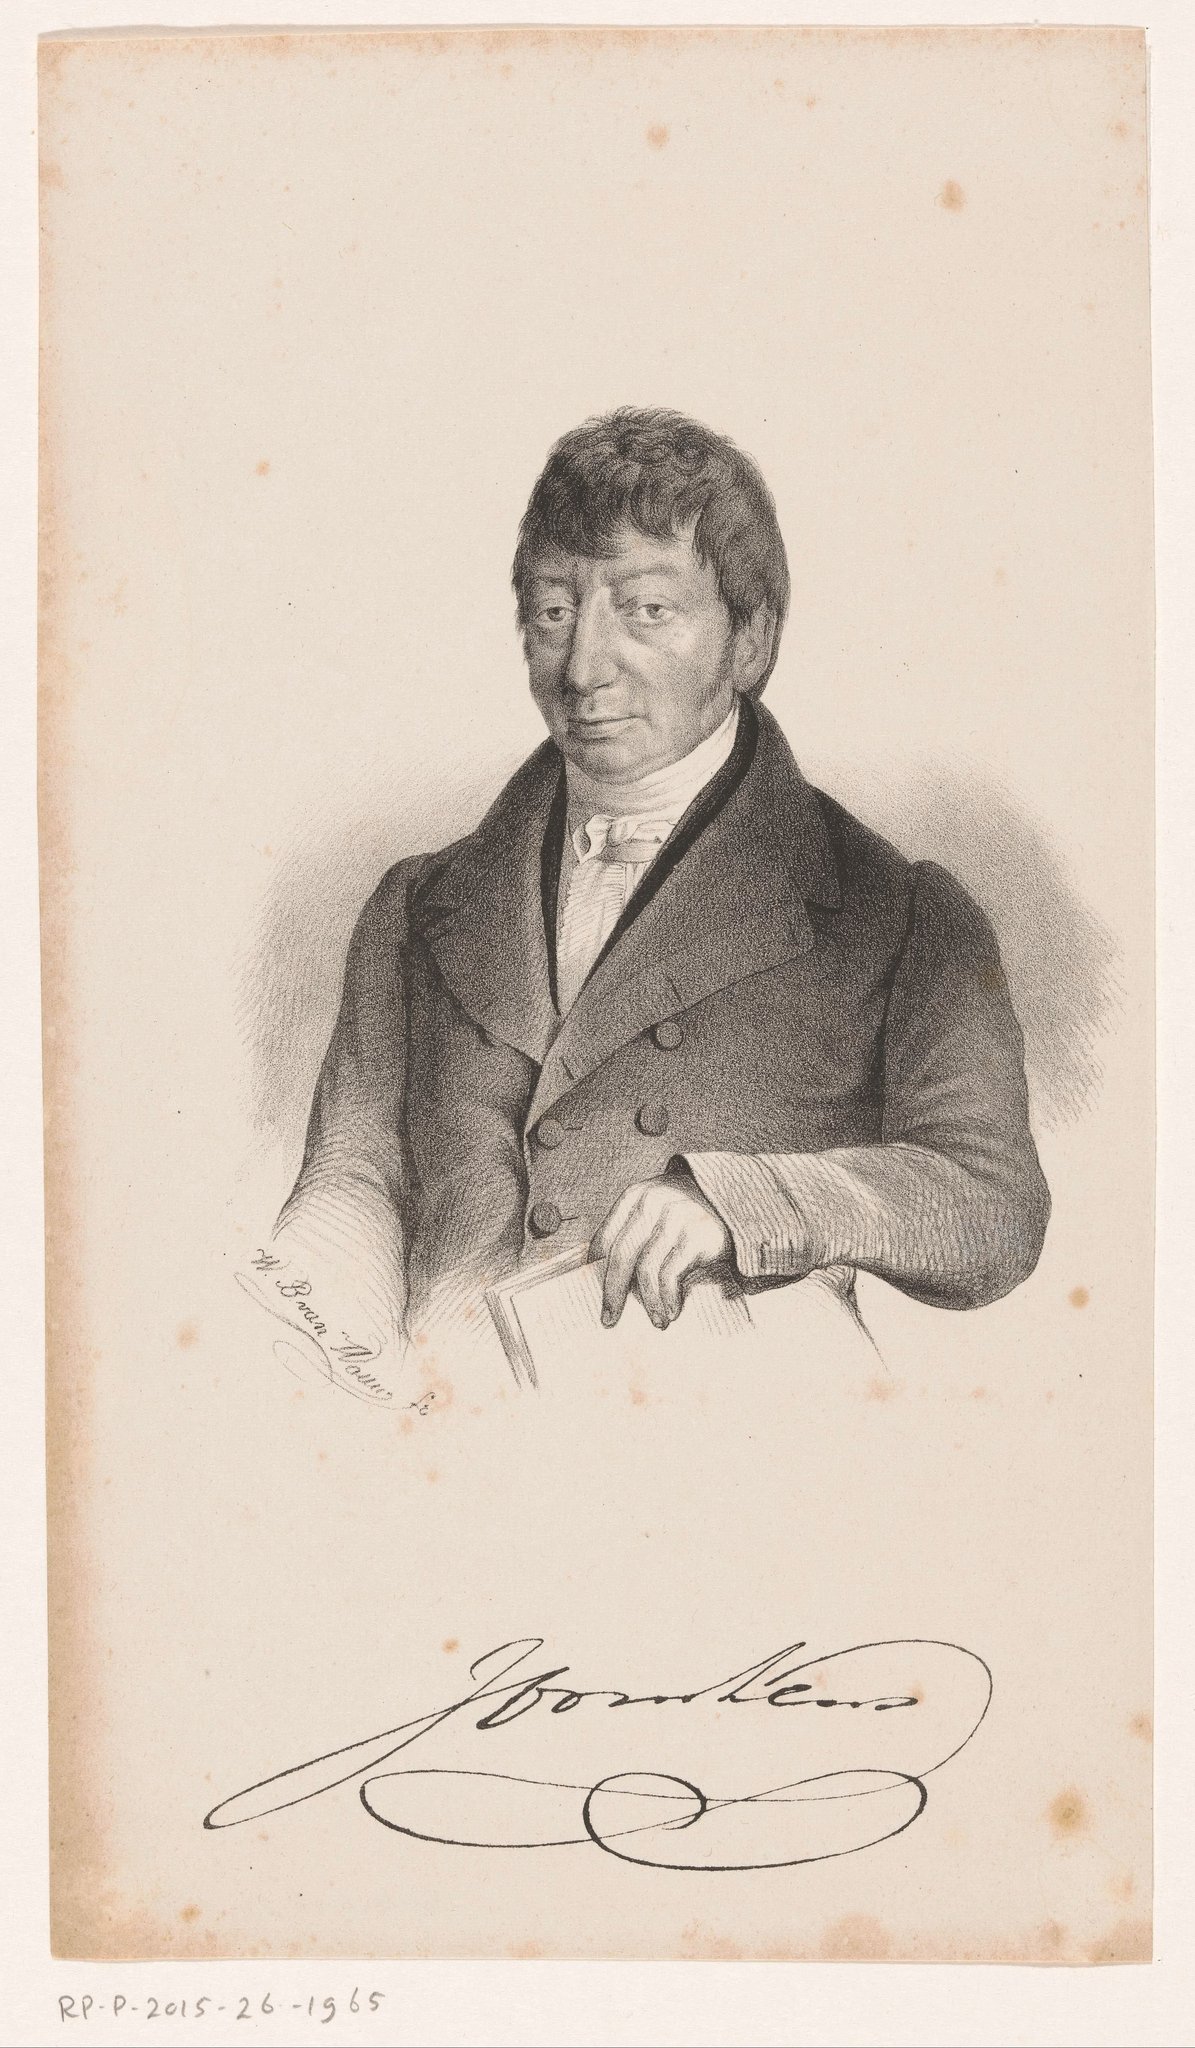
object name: print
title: Portret van Jan Oomkens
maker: willem bastiaan van wouw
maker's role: print maker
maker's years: 1822-1878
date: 1859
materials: paper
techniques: lithograph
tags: printer, bookseller, jan oomkens, publishing, publisher, book-shop, bookseller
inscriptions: collector's mark: Lugt 2228, collector's mark: Lugt 4780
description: Portret van Jan Oomkens, boekhandelaar, uitgever en drukker te Groningen. In zijn linkerhand houdt hij een publicatie vast. Onder het portret zijn signatuur.